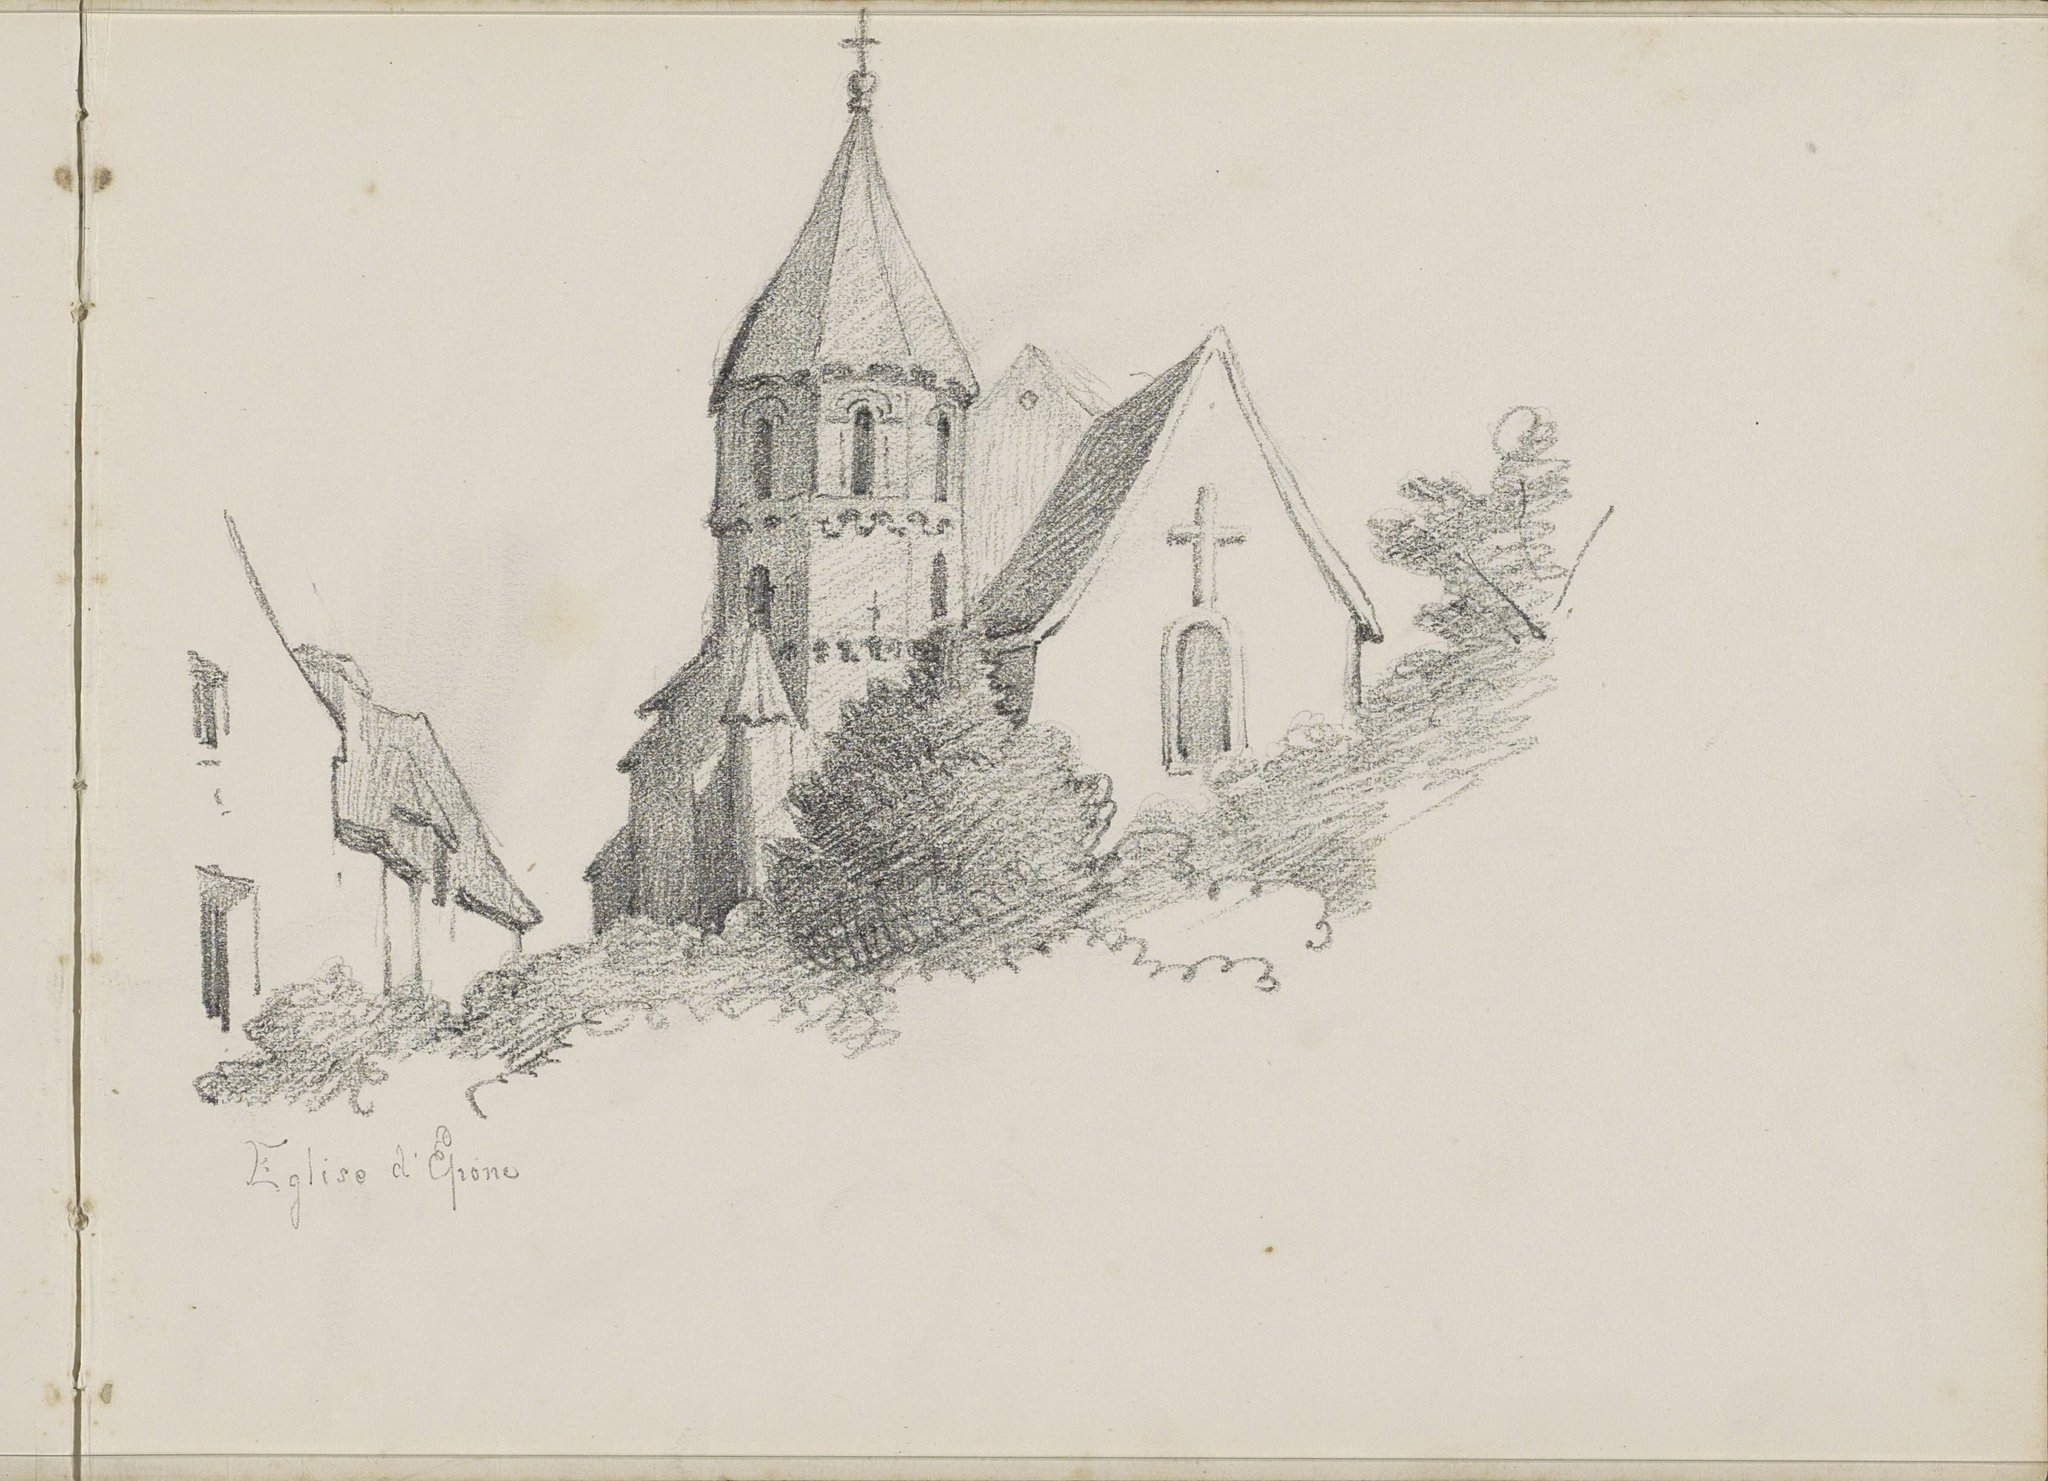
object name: sketchbook leaf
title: Église Saint-Béat te Épône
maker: gerrit postma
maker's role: draughtsman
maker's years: 1819-1894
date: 1858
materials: paper, pencil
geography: épone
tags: church (exterior)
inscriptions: annotation: ‘Eglise d'Epone’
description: Blad 12 recto uit een schetsboek met 52 bladen.